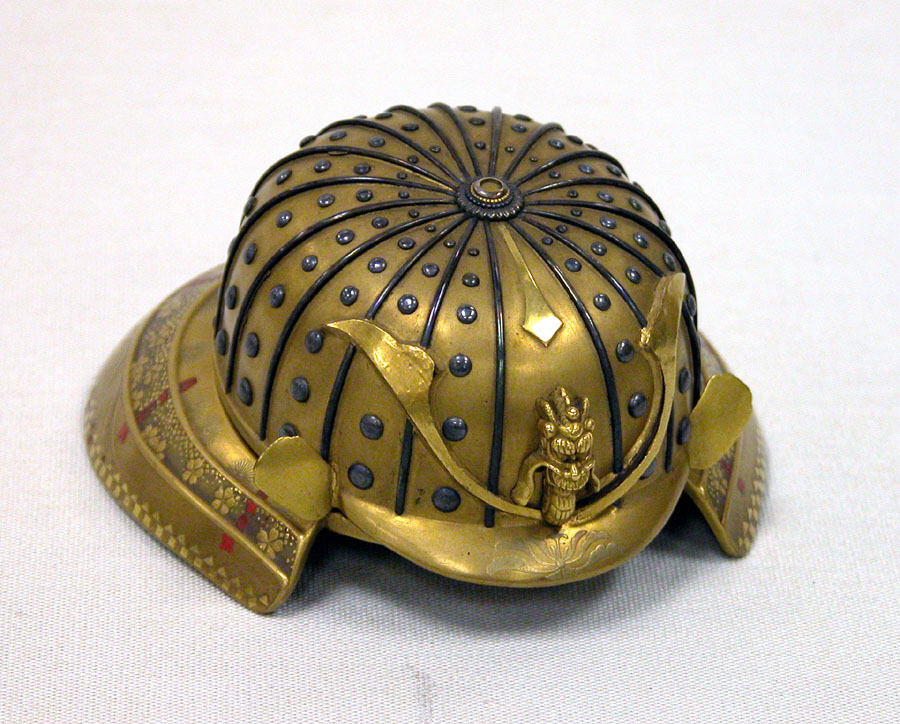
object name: kobako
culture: japanese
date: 1701-1800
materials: gold, lacquer, silver